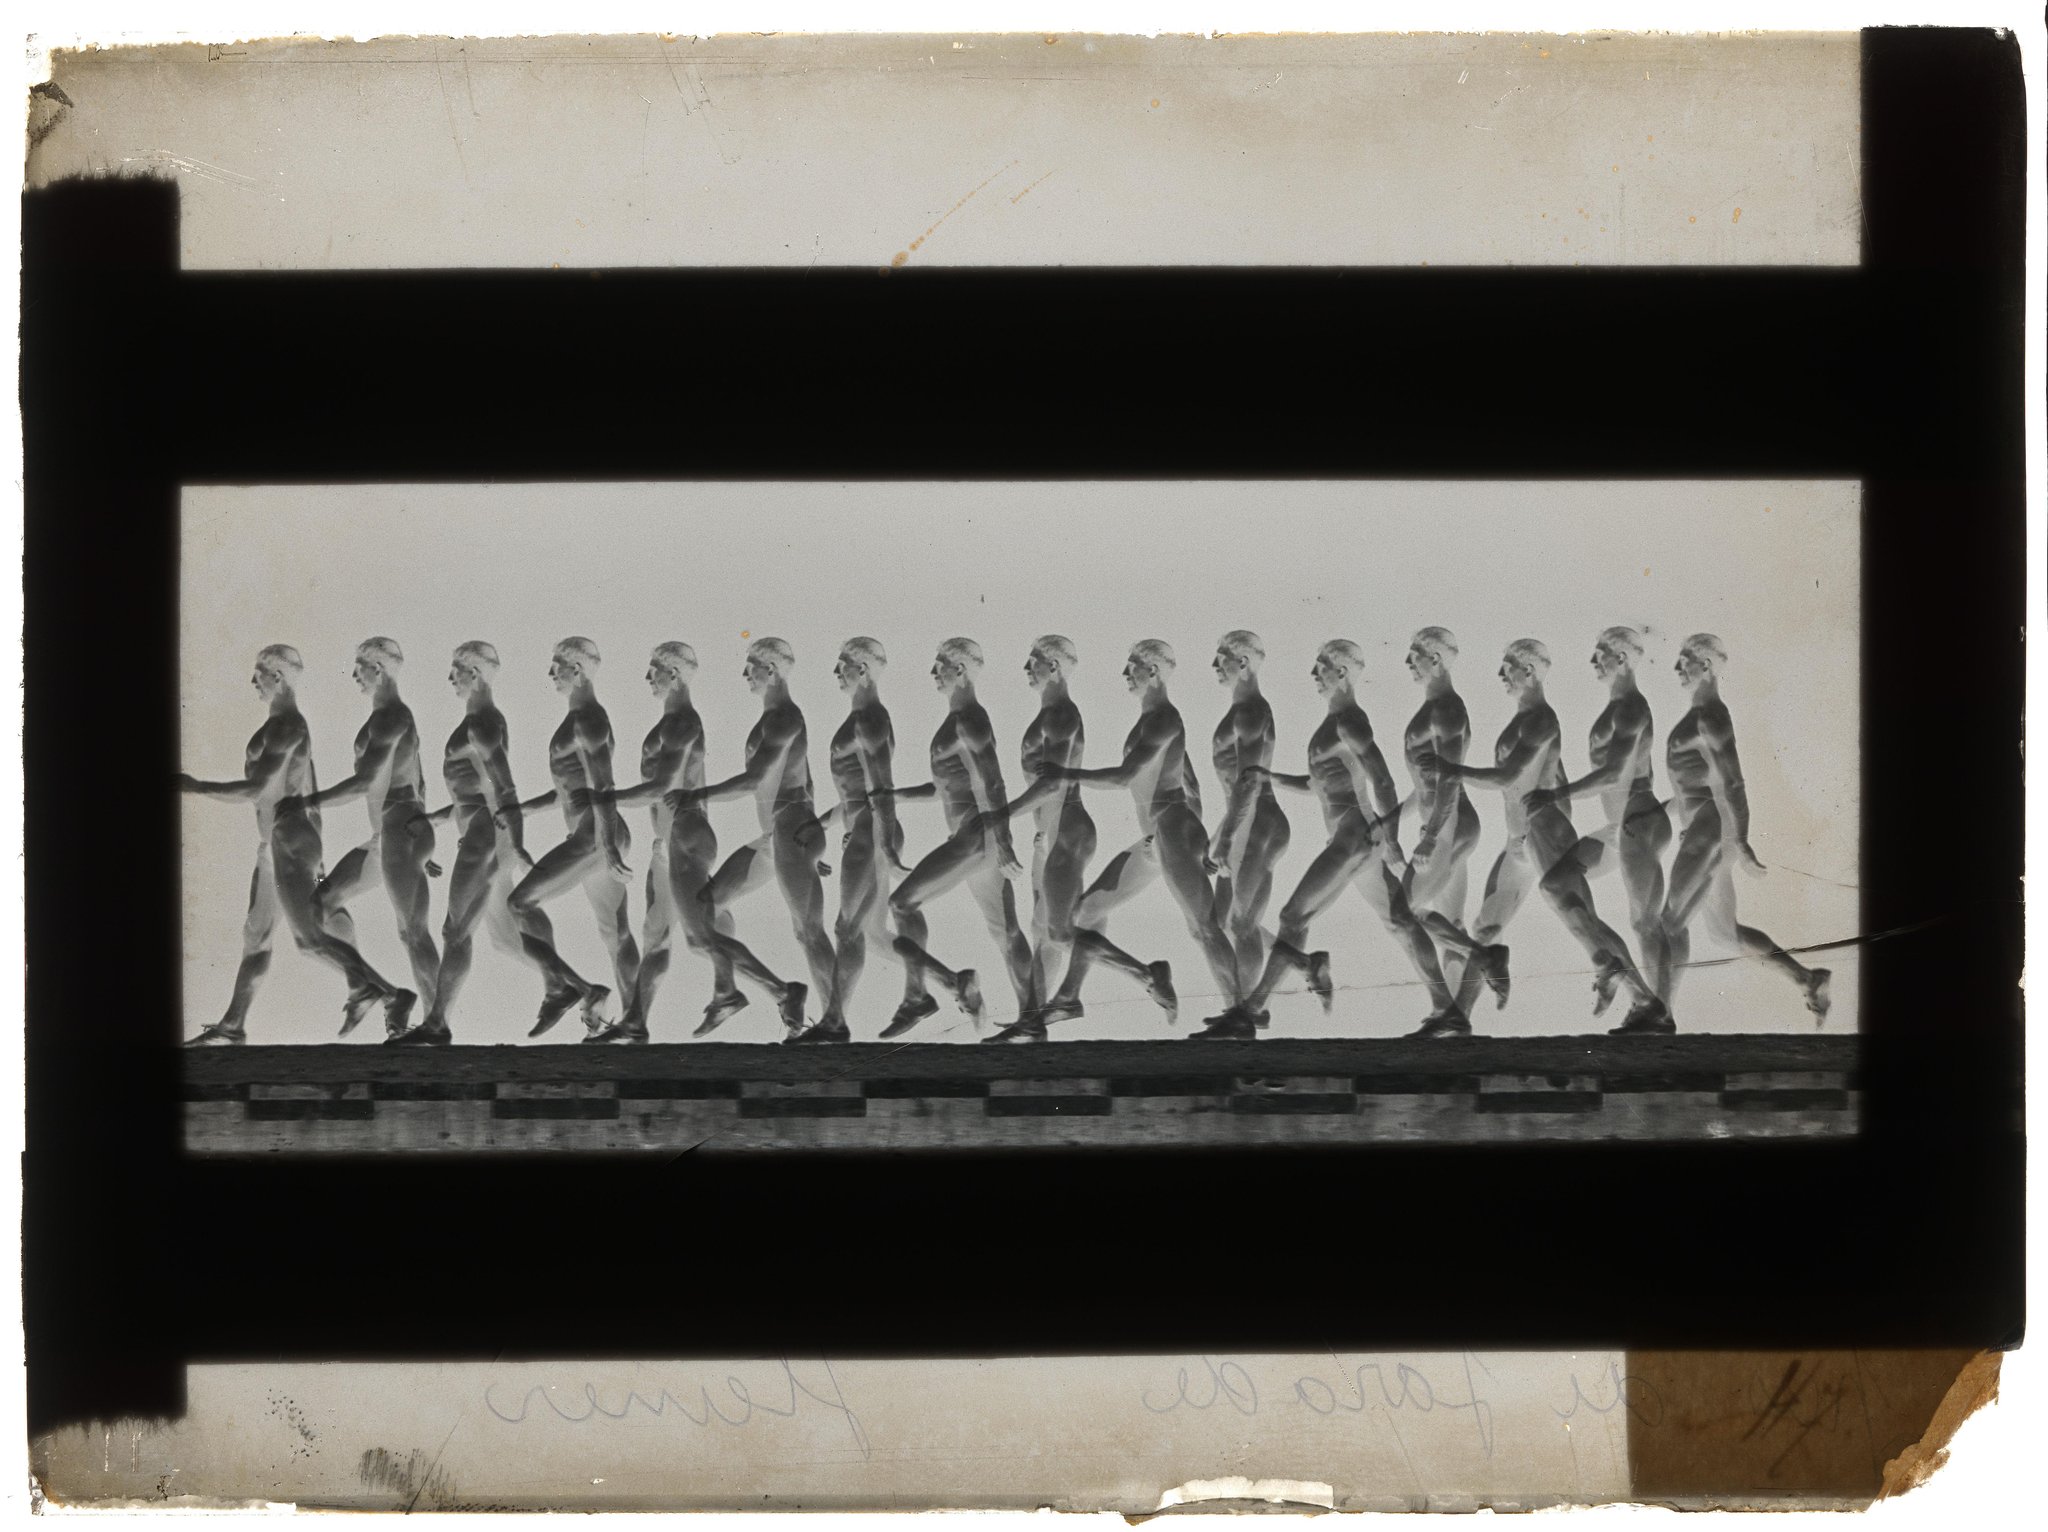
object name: glasnegatief, glasplaatnegatief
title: Man wandelt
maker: étienne-jules marey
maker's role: fotograaf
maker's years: 1830-1904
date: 1882-1890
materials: glass, paper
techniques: gelatin glass negative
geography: france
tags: movements of the human body, adult man, walking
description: Bij de negatieven zijn ook de duplicaatnegatieven en moderne afdrukken die voor de boekpublicatie vervaardigd zijn.